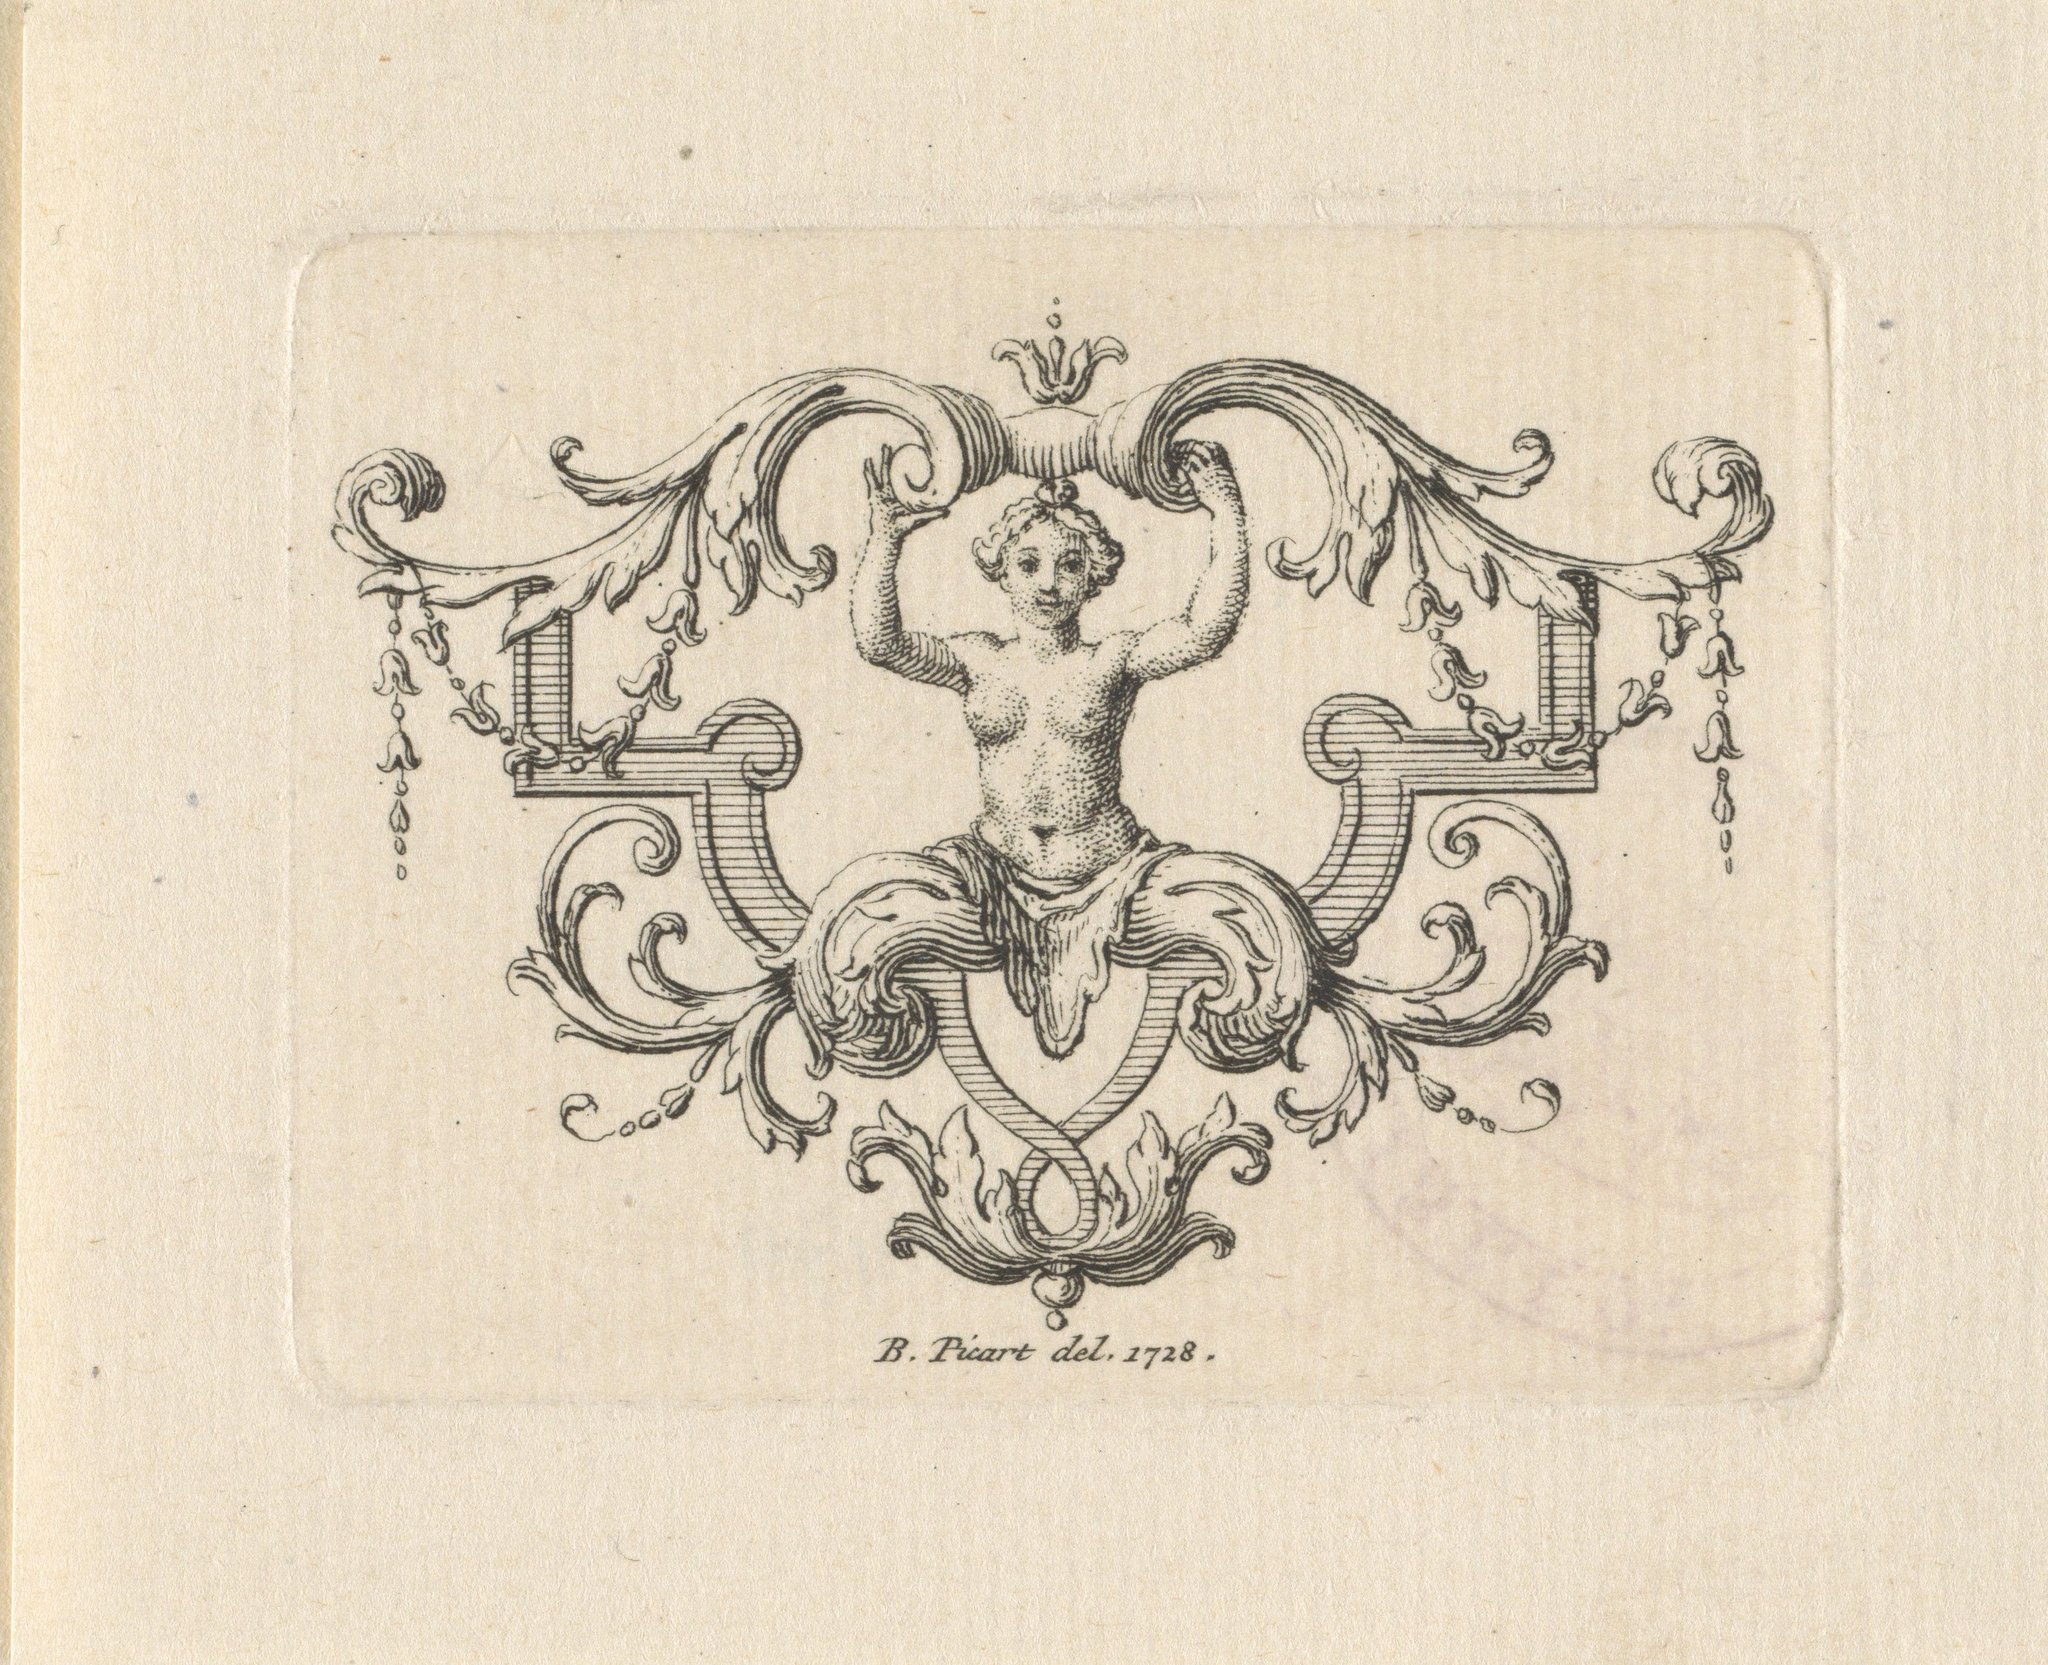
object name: ornament print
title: Ornament met vrouwelijk halffiguur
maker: bernard picart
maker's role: draughtsman, print maker, publisher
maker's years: 1673-1733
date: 1728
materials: paper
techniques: engraving, etching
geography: amsterdam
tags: ornament ~ human parts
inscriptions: collector's mark: Lugt 240